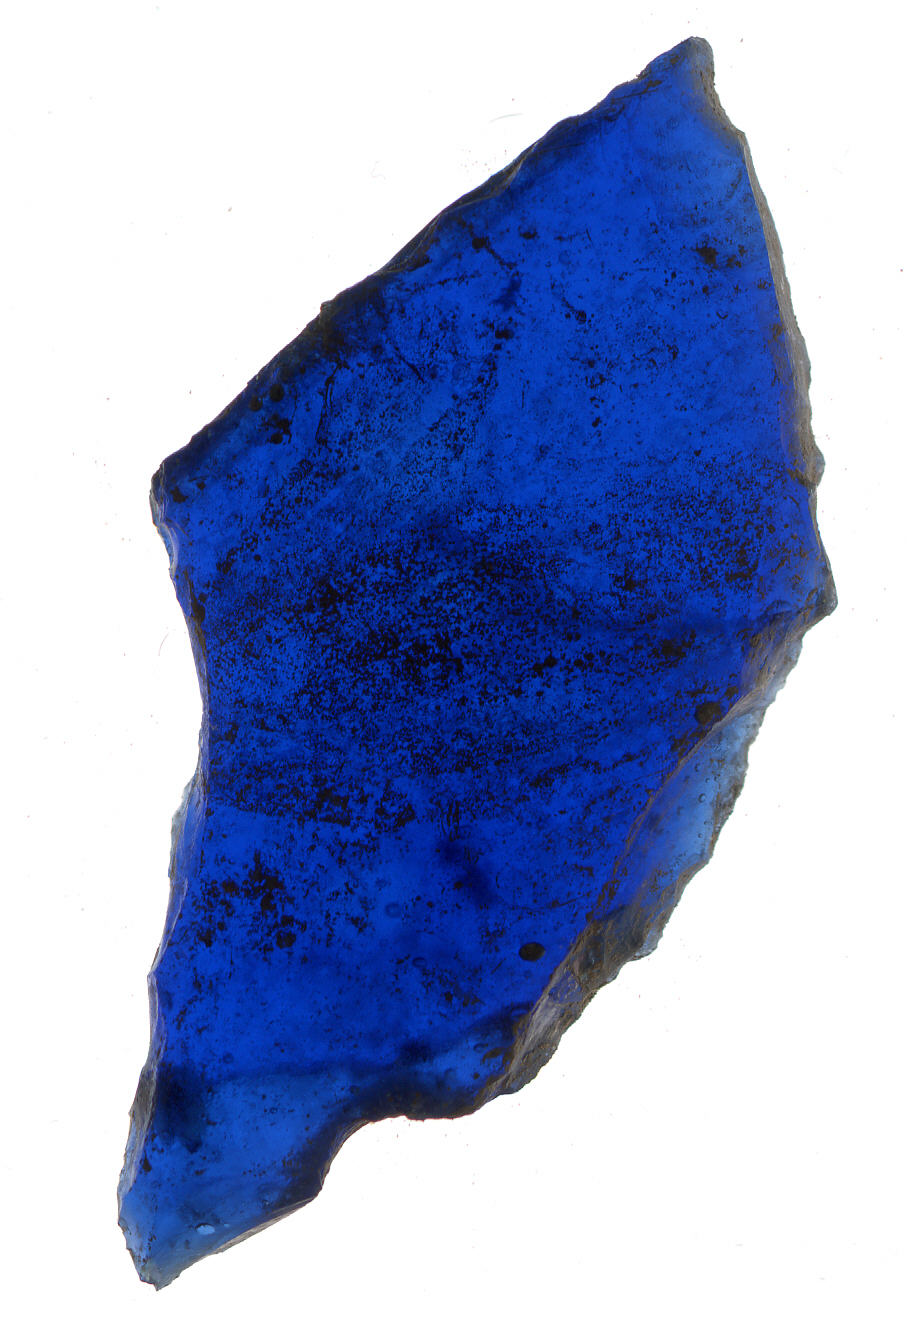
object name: fragment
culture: crusader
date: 1201-1300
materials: glass